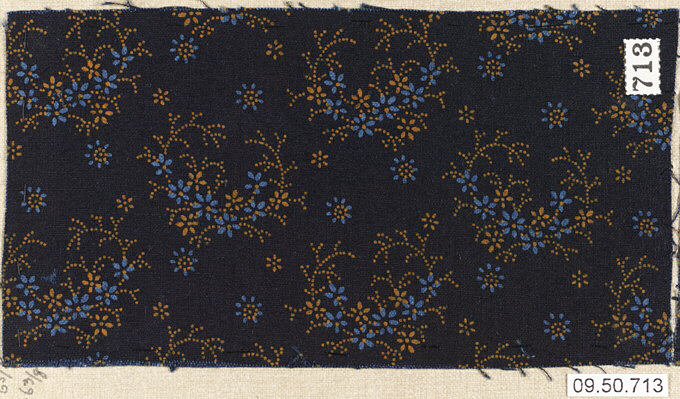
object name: piece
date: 1801-1900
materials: cotton